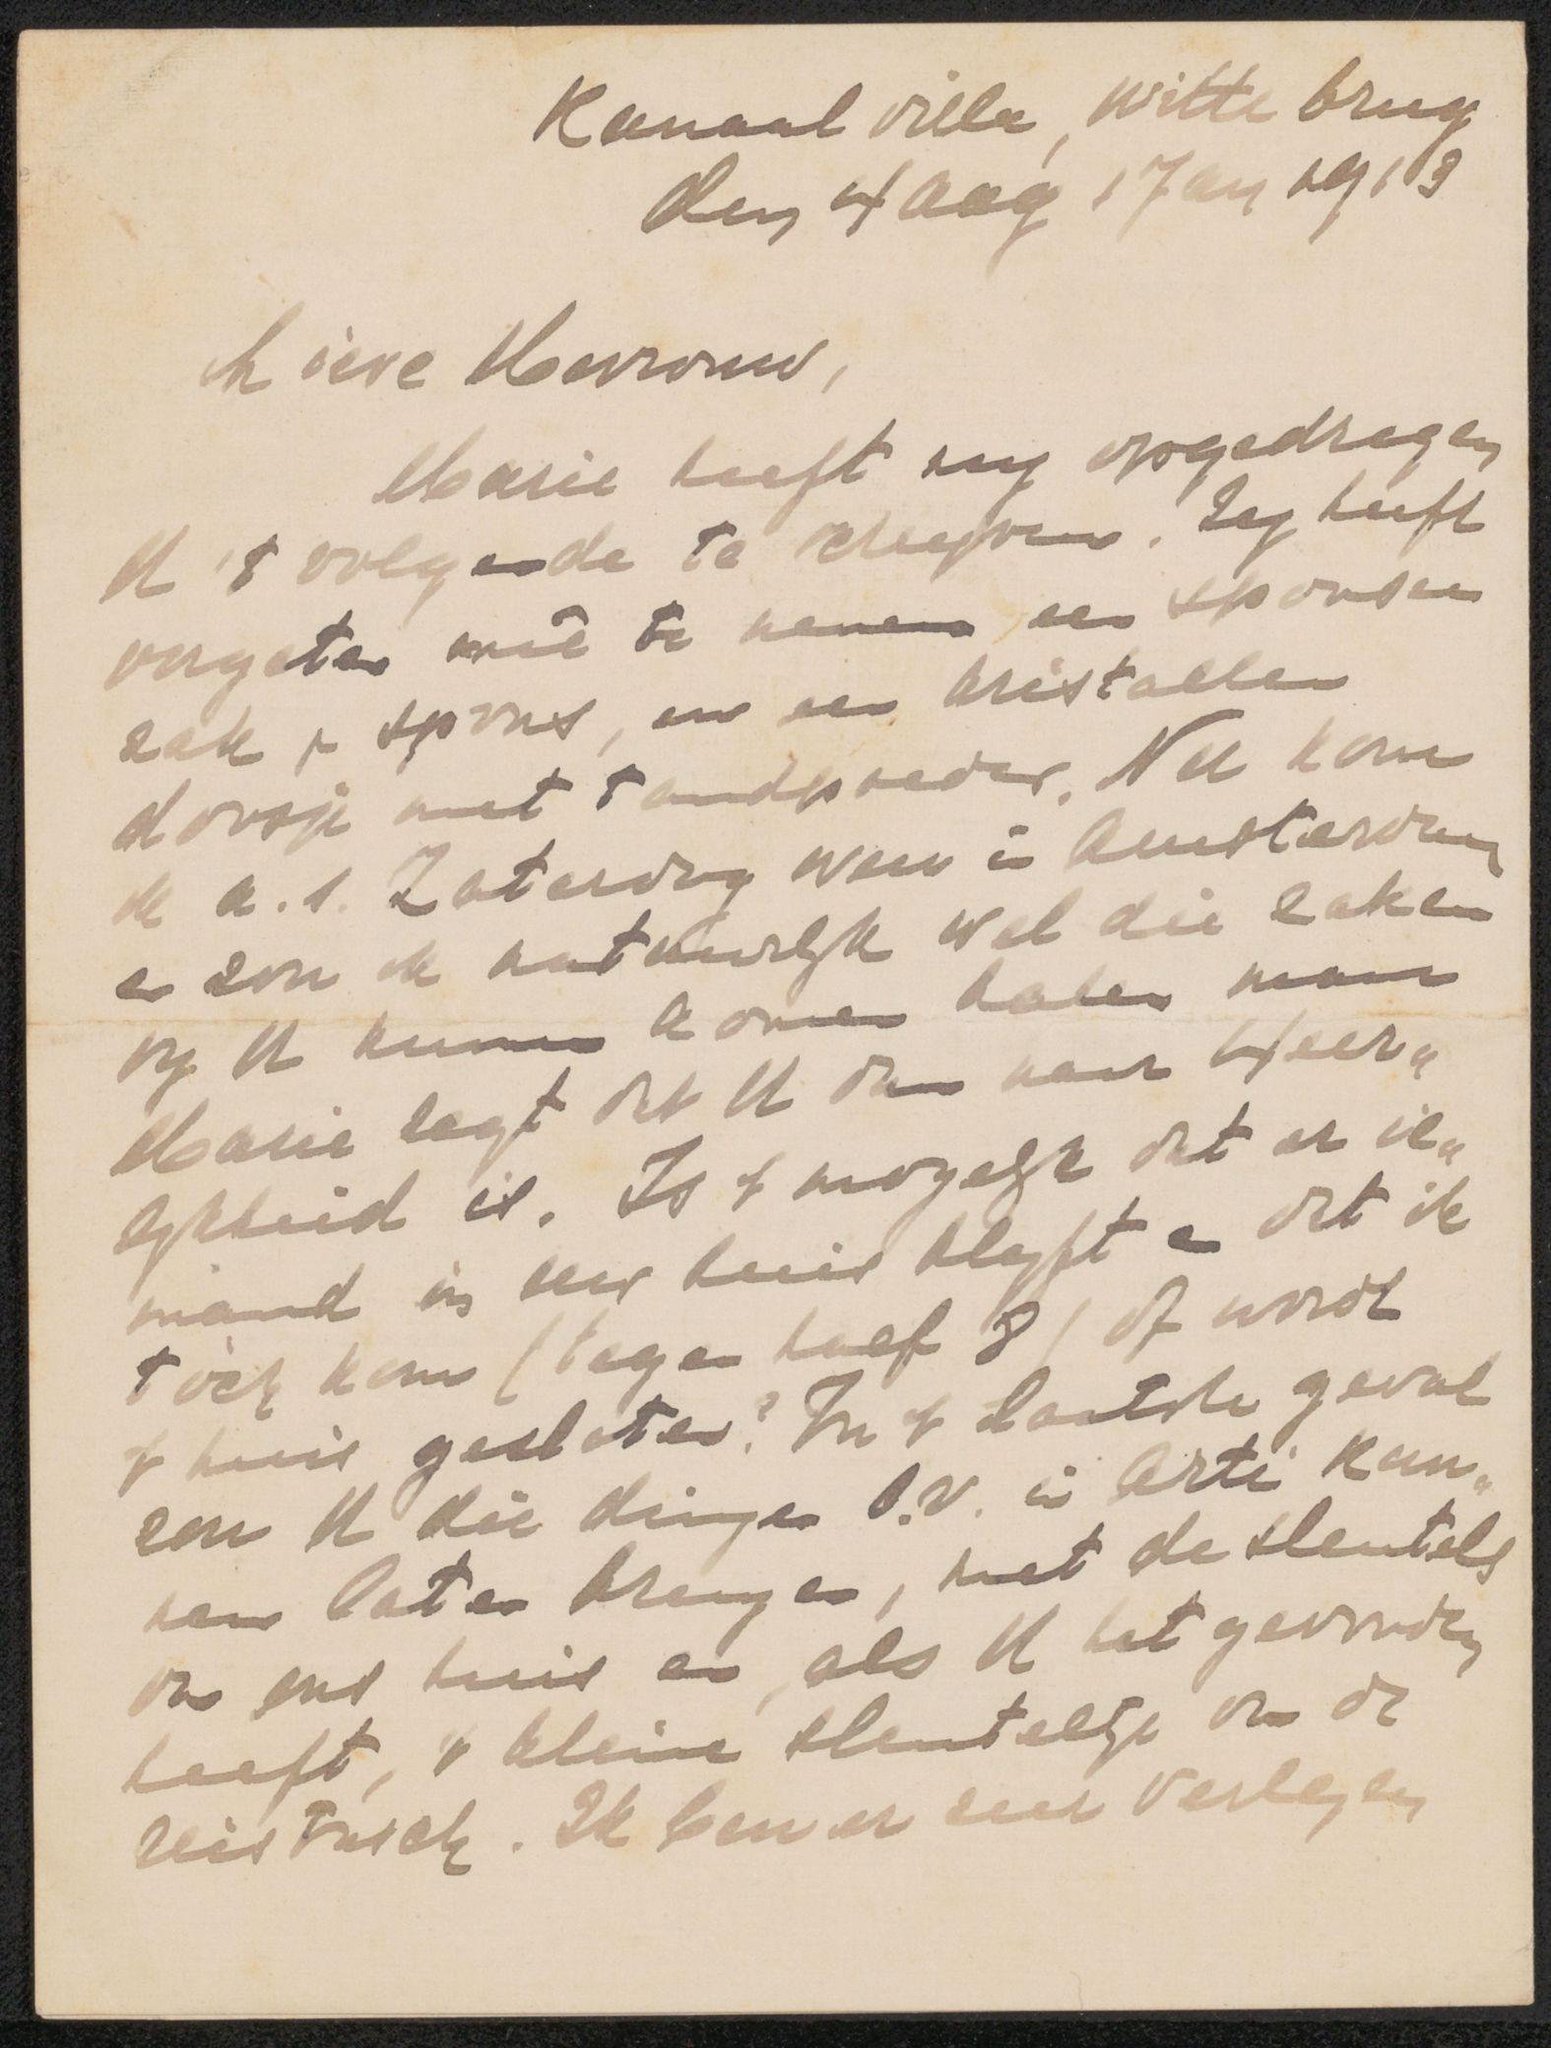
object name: letter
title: Brief aan mevrouw Den Tex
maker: willem witsen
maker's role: draughtsman, painter, print maker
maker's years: 1860-1923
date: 1913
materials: ink, paper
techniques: pen, writing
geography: the hague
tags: augusta maria agnes witsen-schorr, the graphic arts, amsterdam